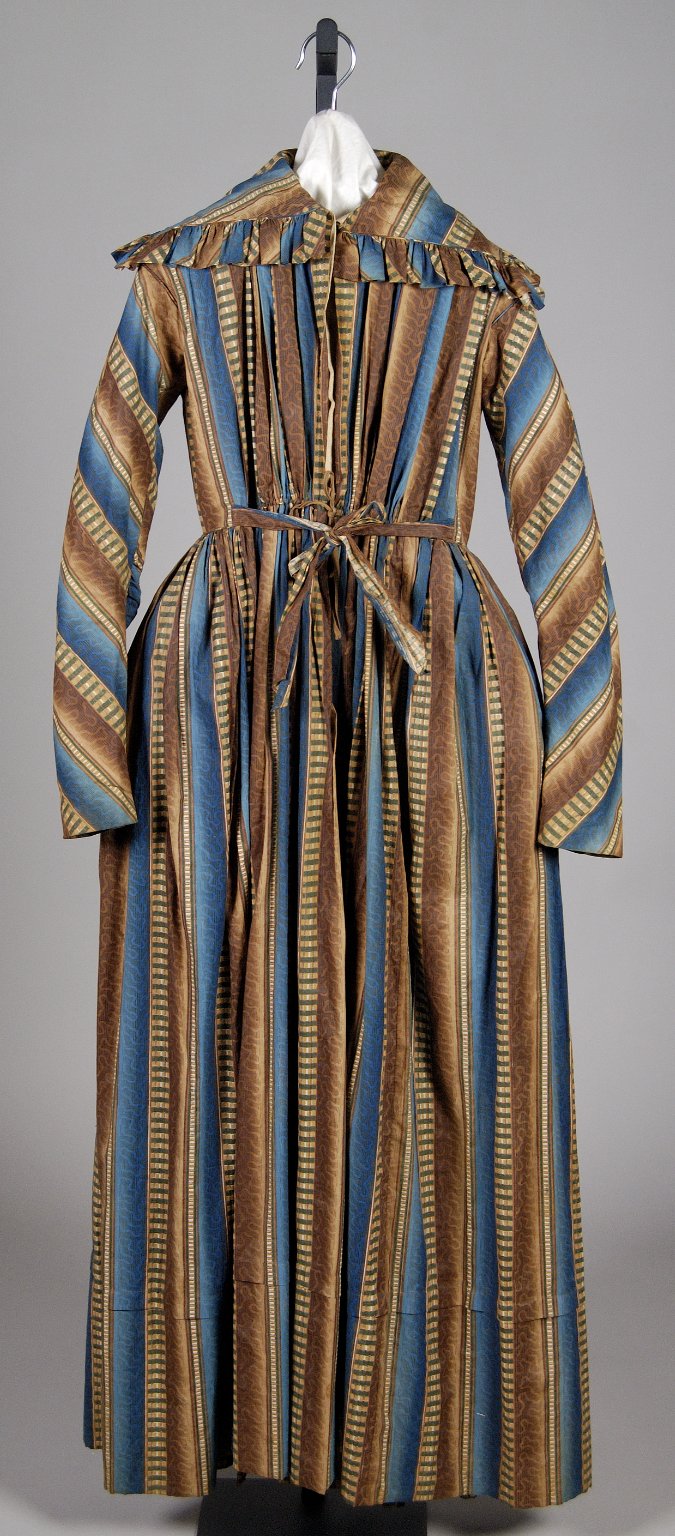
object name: wrapper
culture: american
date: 1840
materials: cotton